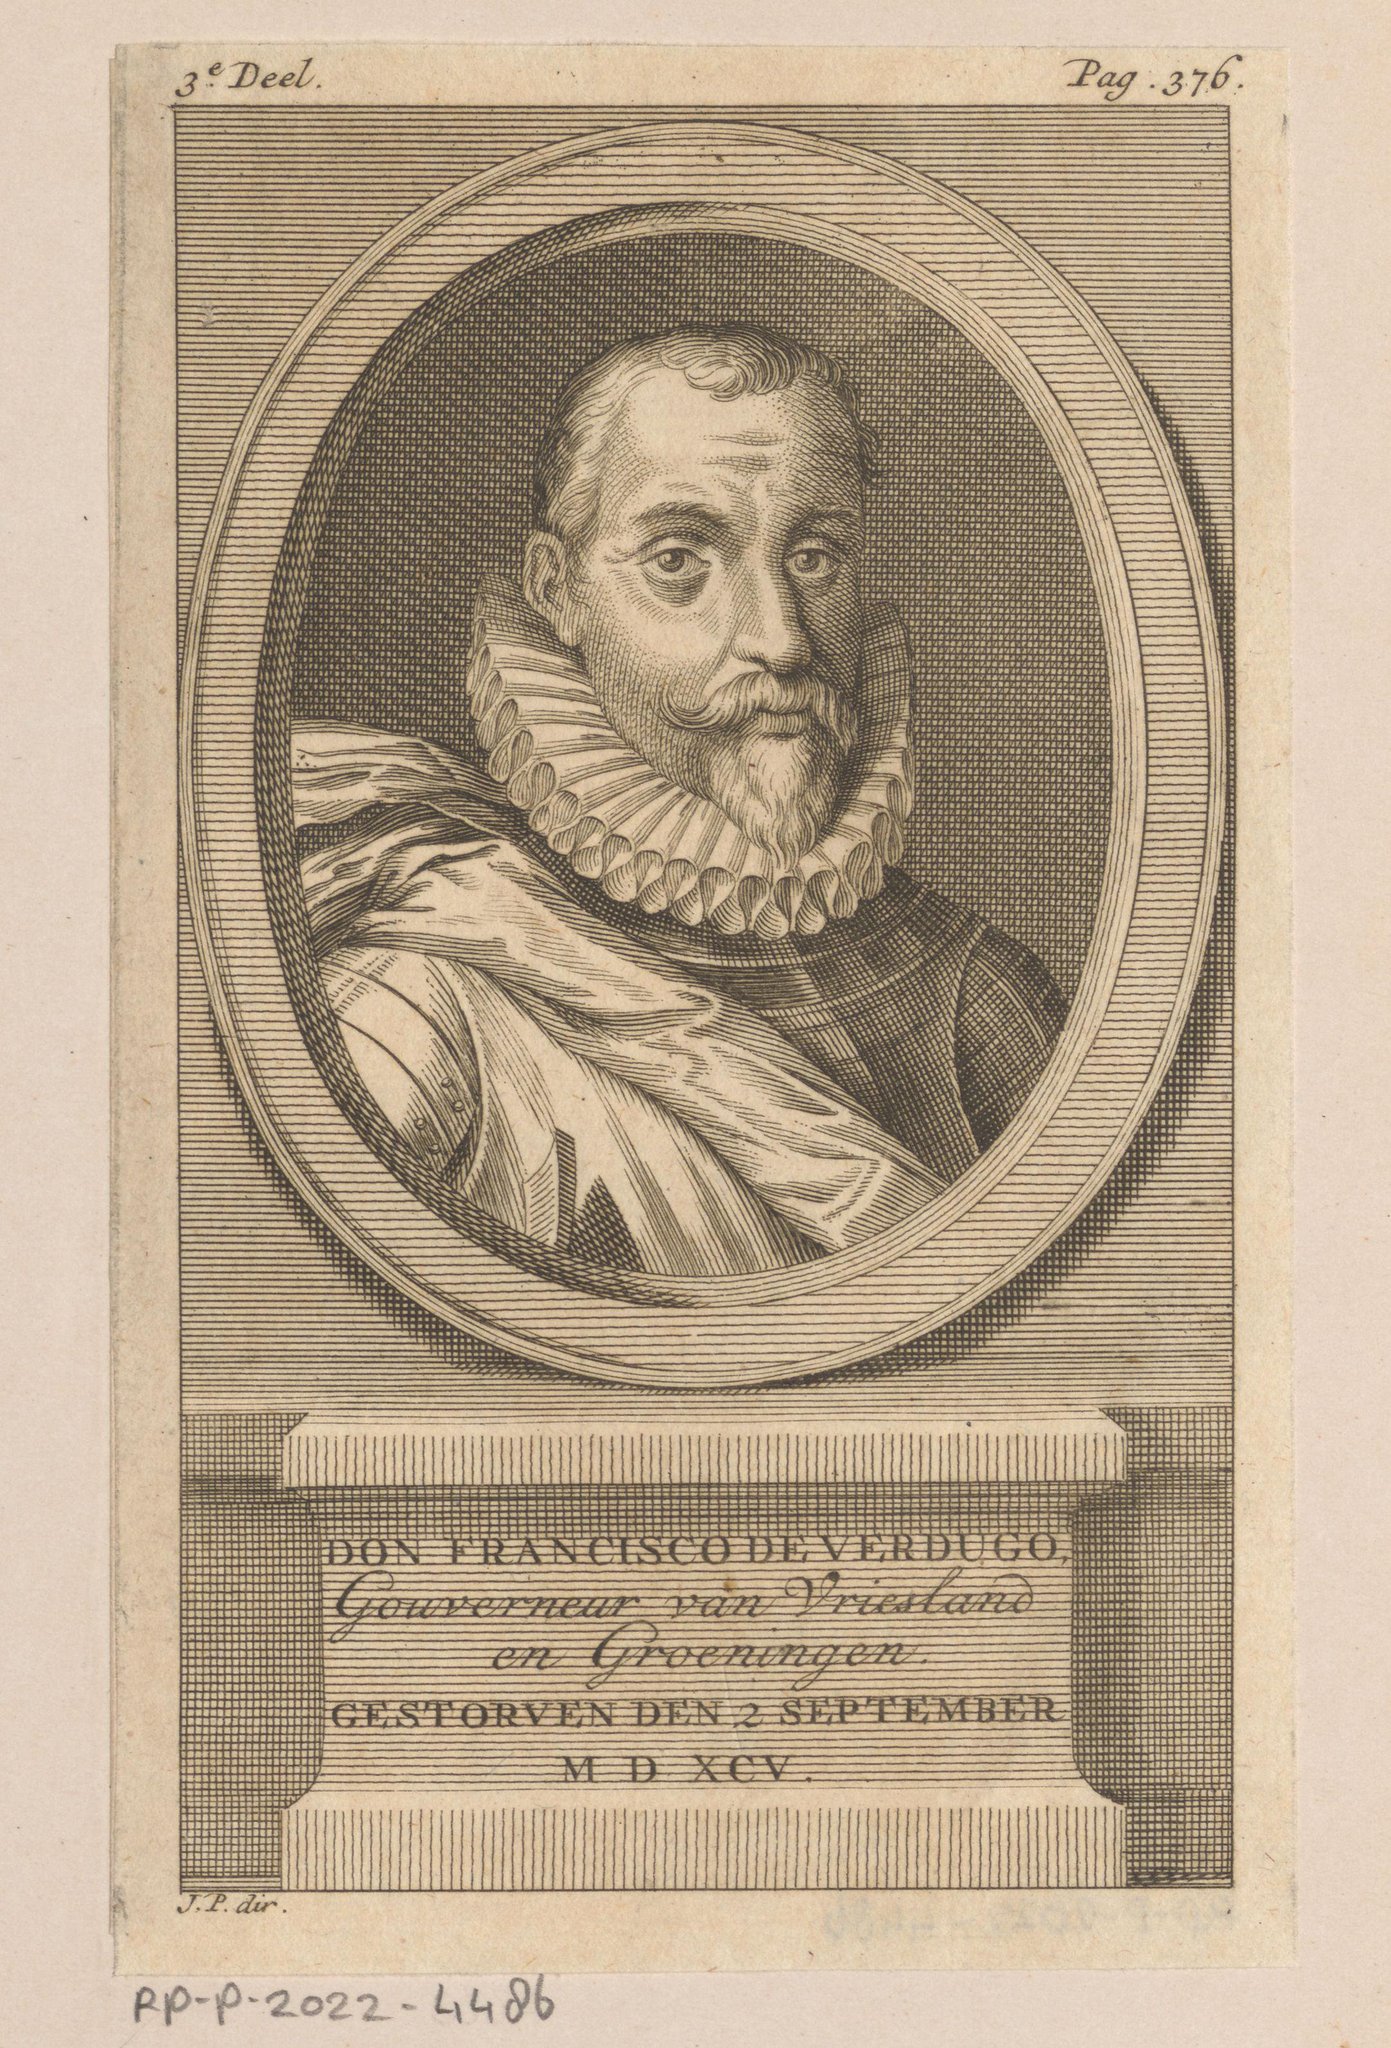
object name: print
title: Portret van Francisco Verdugo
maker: jan punt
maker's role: draughtsman, print maker, publisher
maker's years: 1711-1779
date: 1750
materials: paper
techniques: engraving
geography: northern netherlands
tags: historical persons, stadtholder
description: Prent waarschijnlijk uit: Meteren, Emanuel van. Historie van de oorlogen en geschiedenissen der Nederlanderen, en der zelver naburen: (...). Gorinchem en Breda: Nicolaas en Willem Goetzee, 1750, dl. 3, p. 376